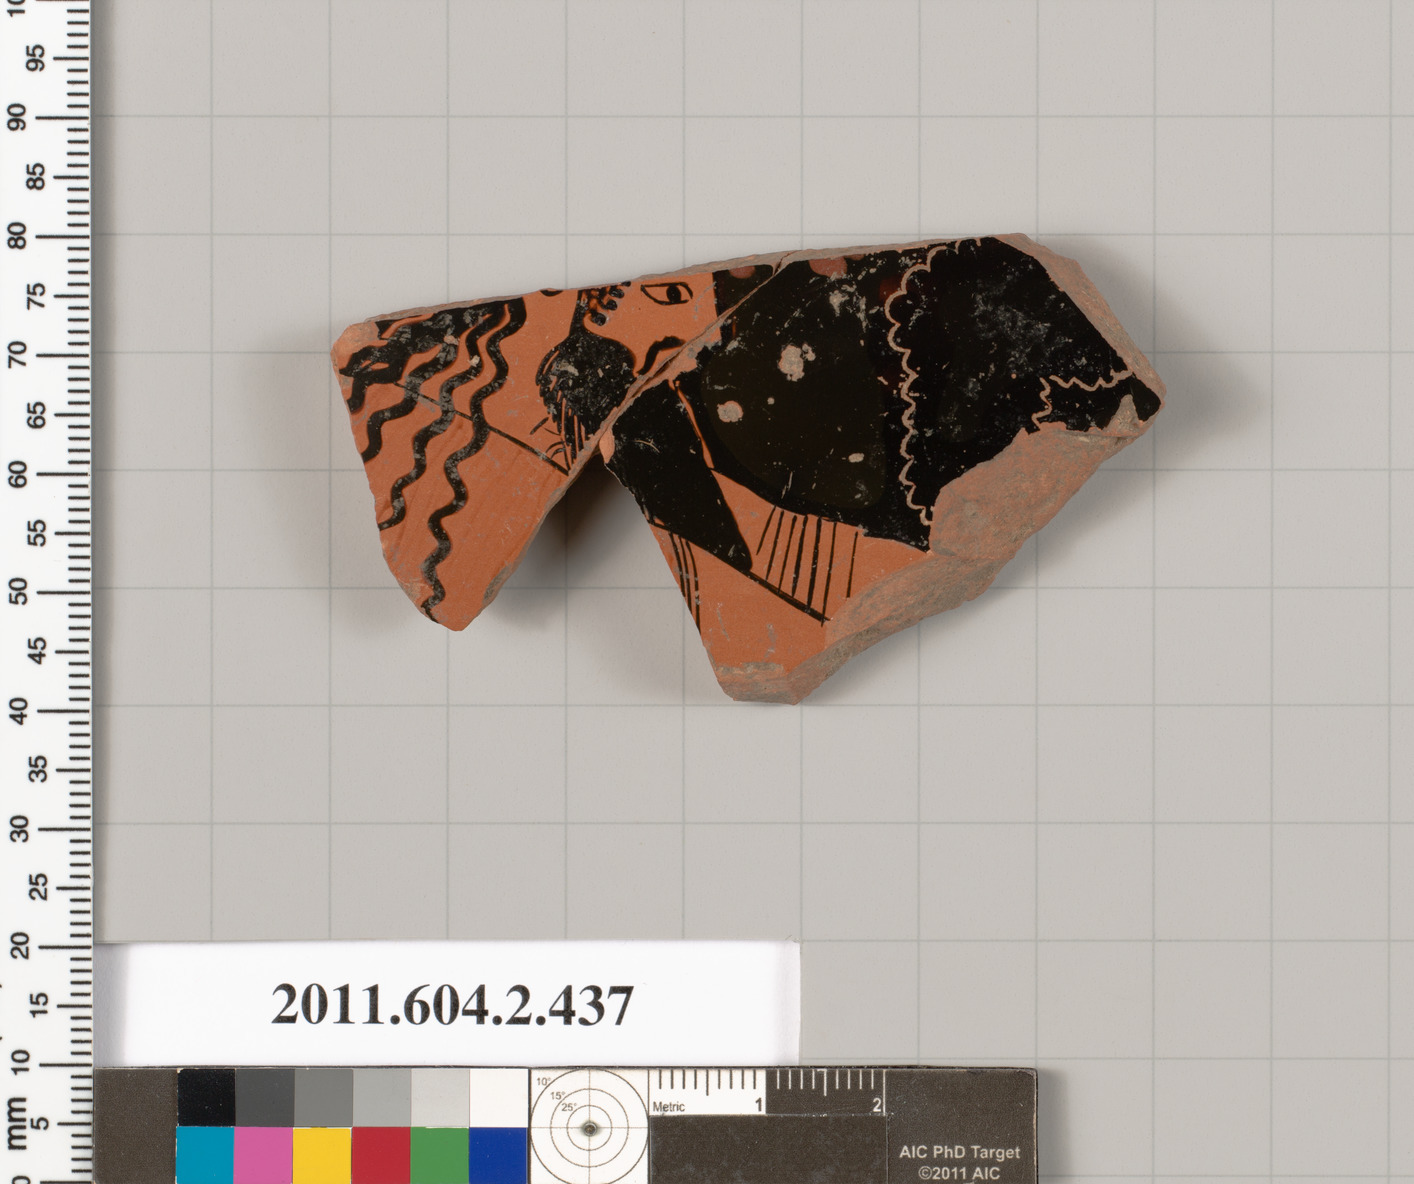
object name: column krater fragment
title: Terracotta fragment of a column-krater (bowl for mixing wine and water)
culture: greek, attic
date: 490-480 BCE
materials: terracotta